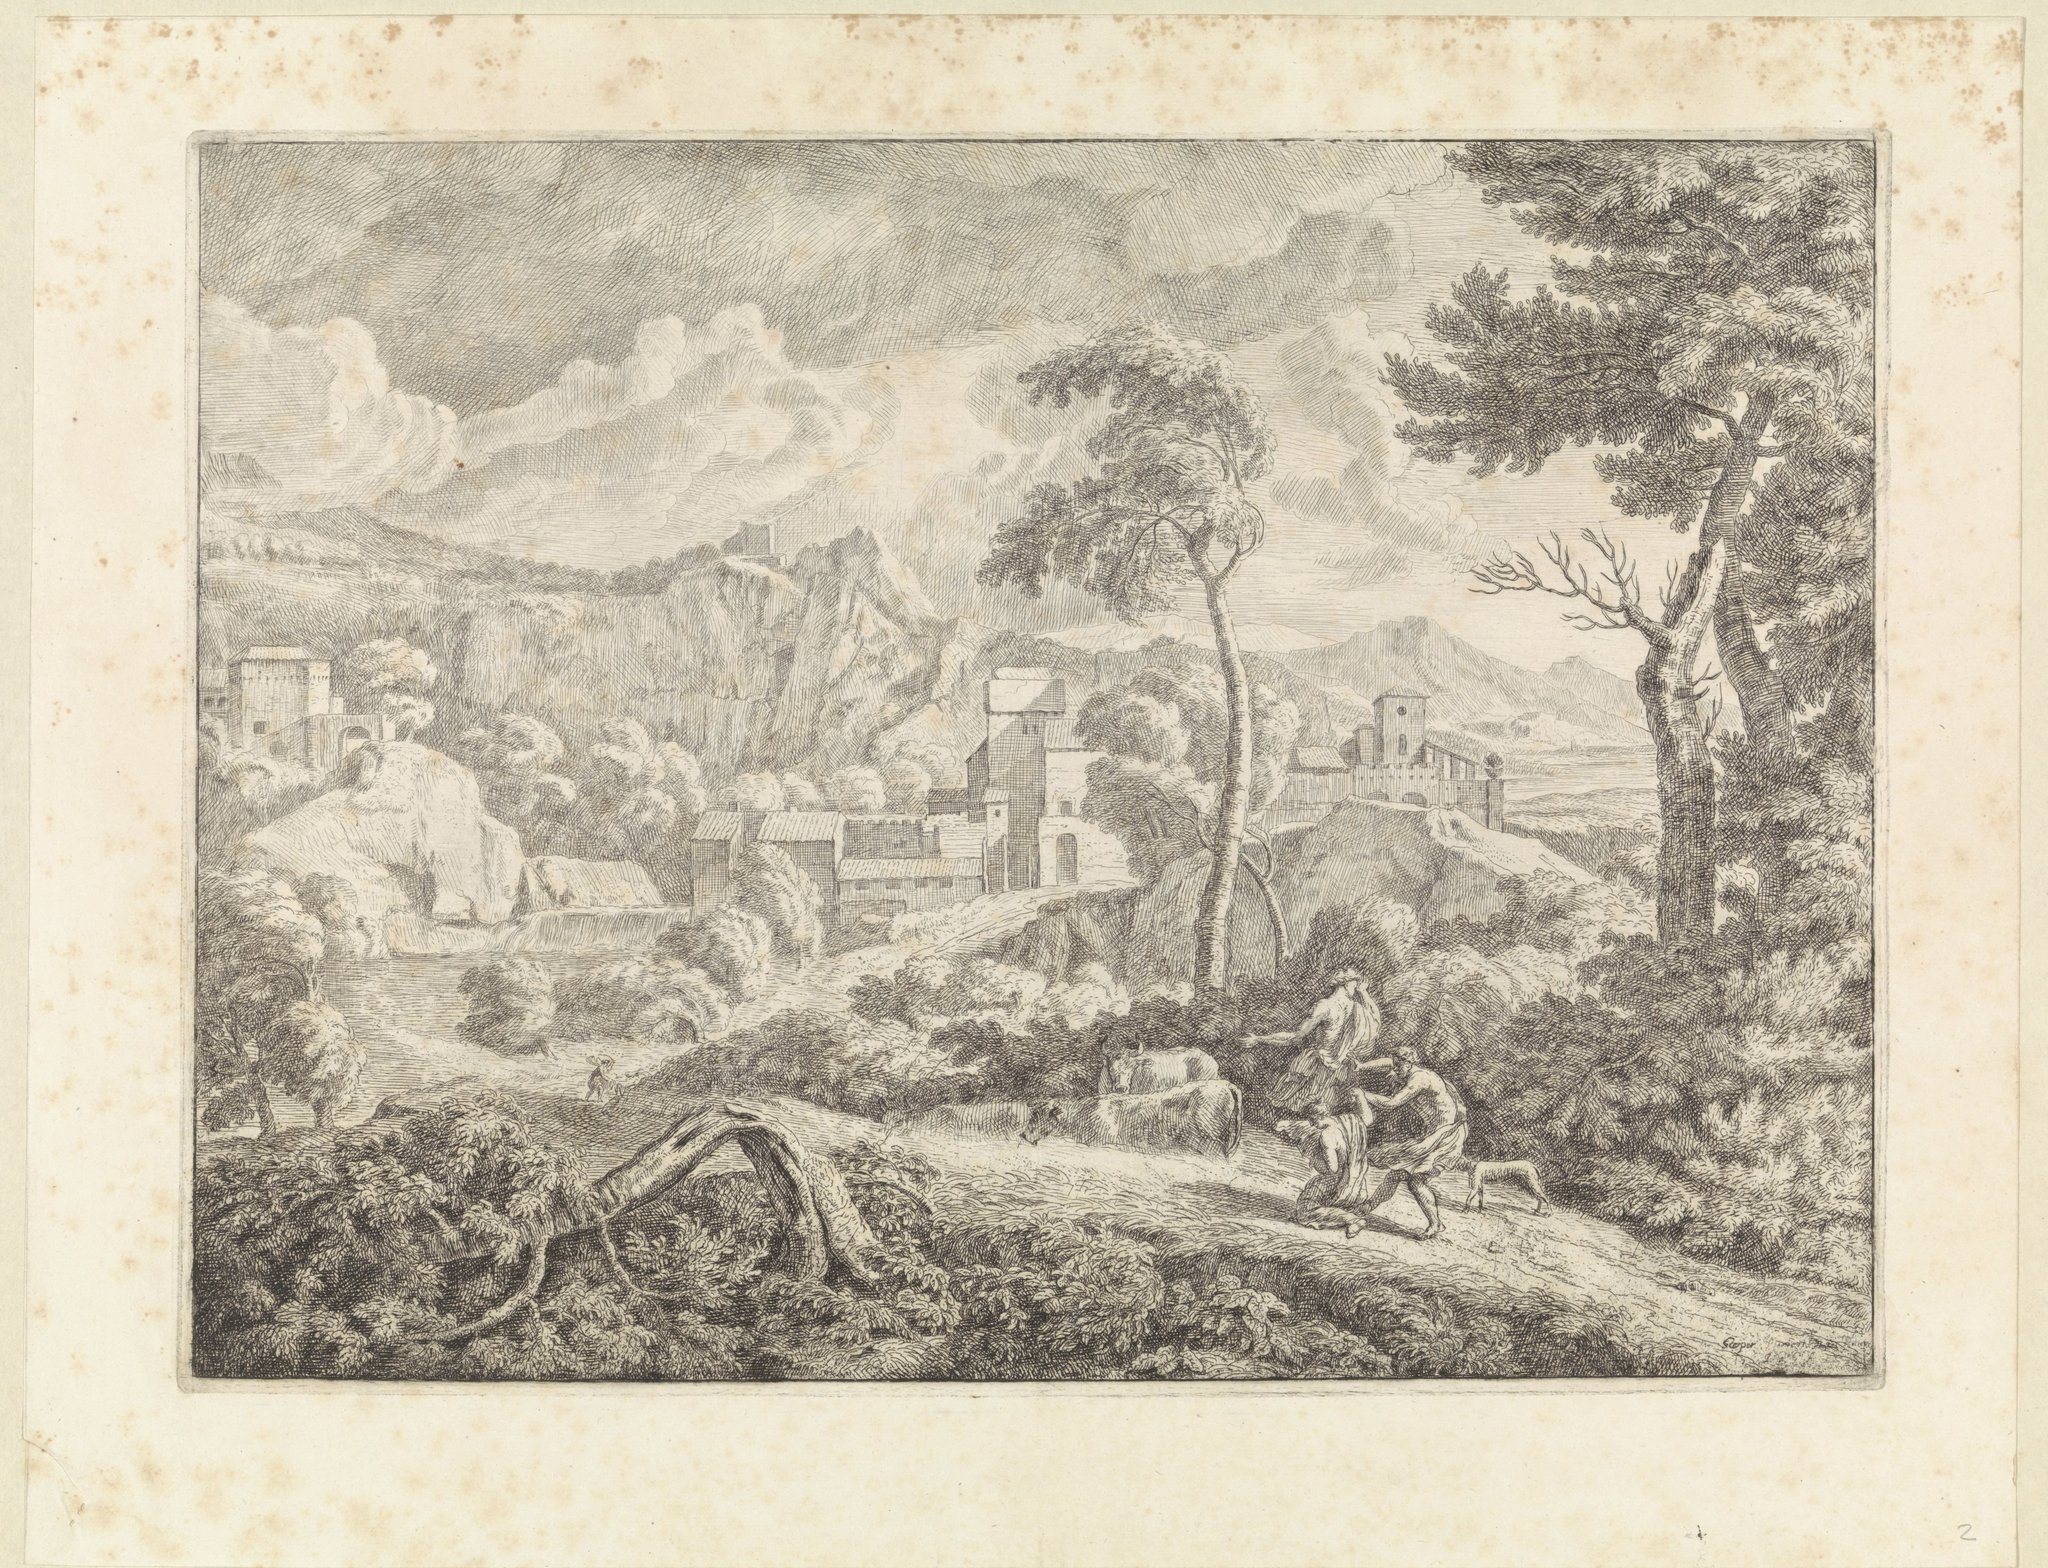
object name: print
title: Drie herders in een storm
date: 1666-1703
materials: paper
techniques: etching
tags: landscapes, herding, herdsman, herdswoman, shepherd, shepherdess, cowherd, etc., storm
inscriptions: collector's mark: Lugt 240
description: In een storm drijven drie herders hun vee naar de stad. Naast de weg een boom door de bliksem gespleten.